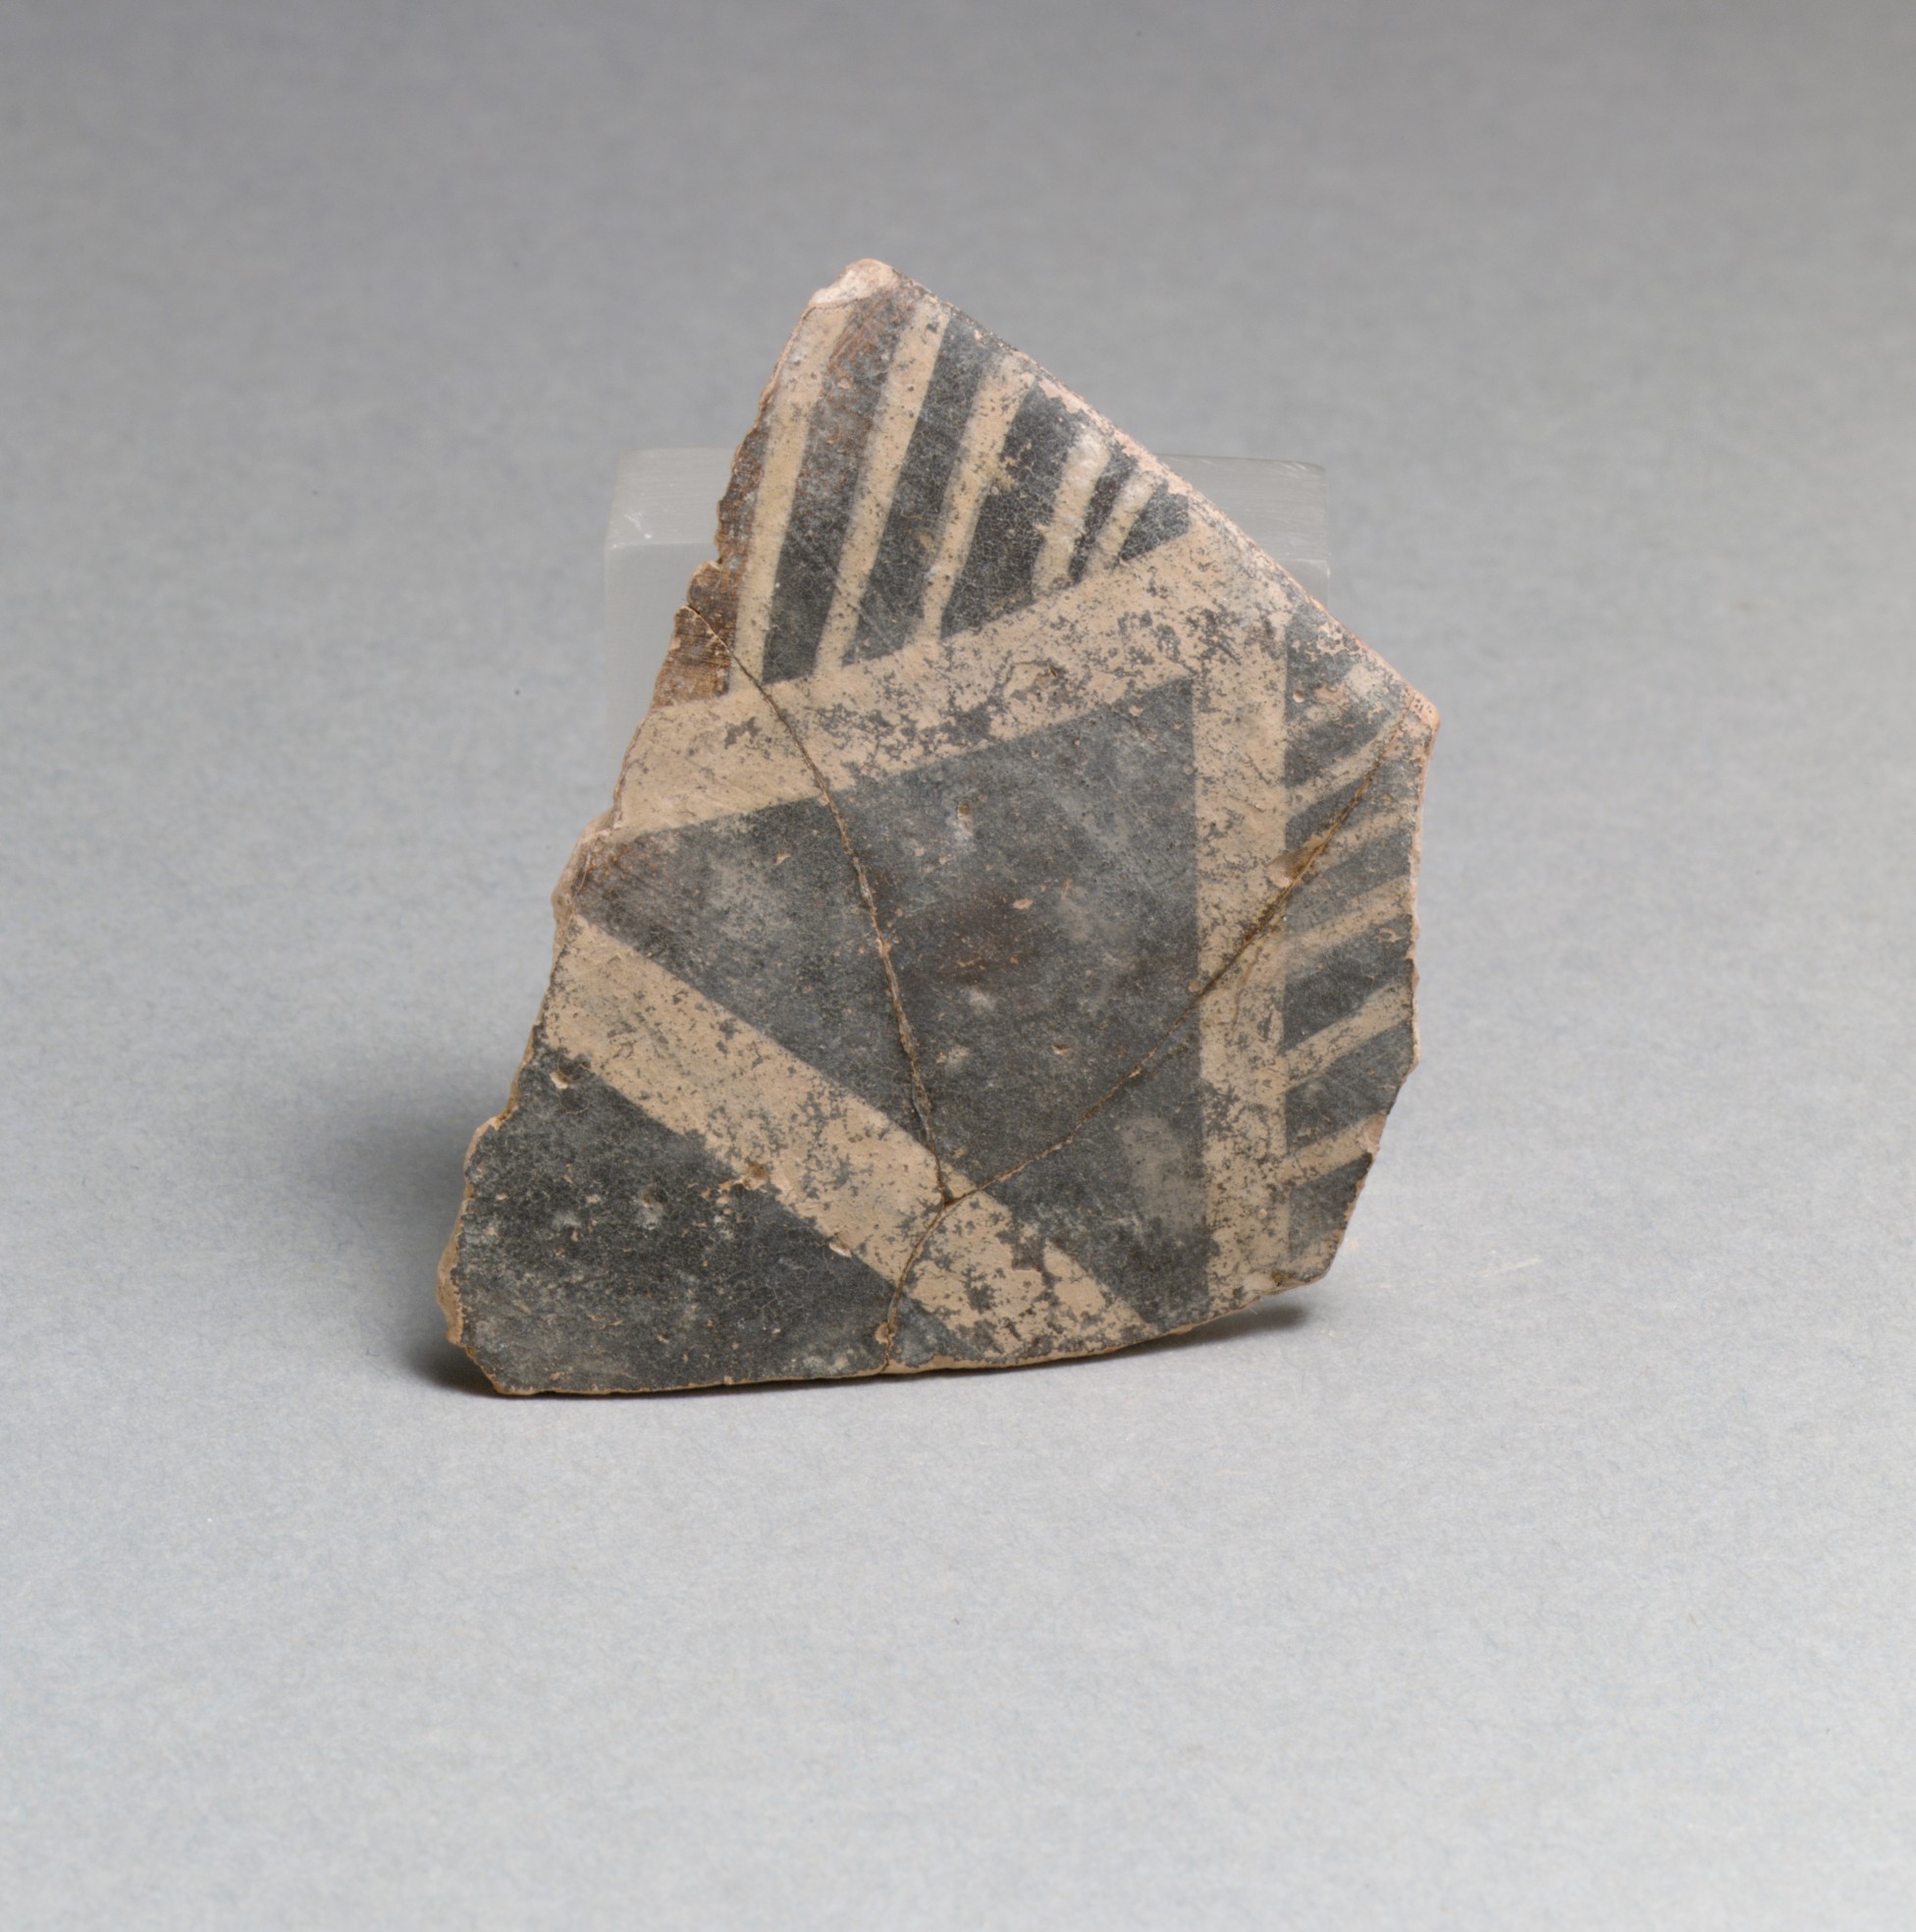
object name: vase fragment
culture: minoan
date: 2600-2000 BCE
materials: terracotta